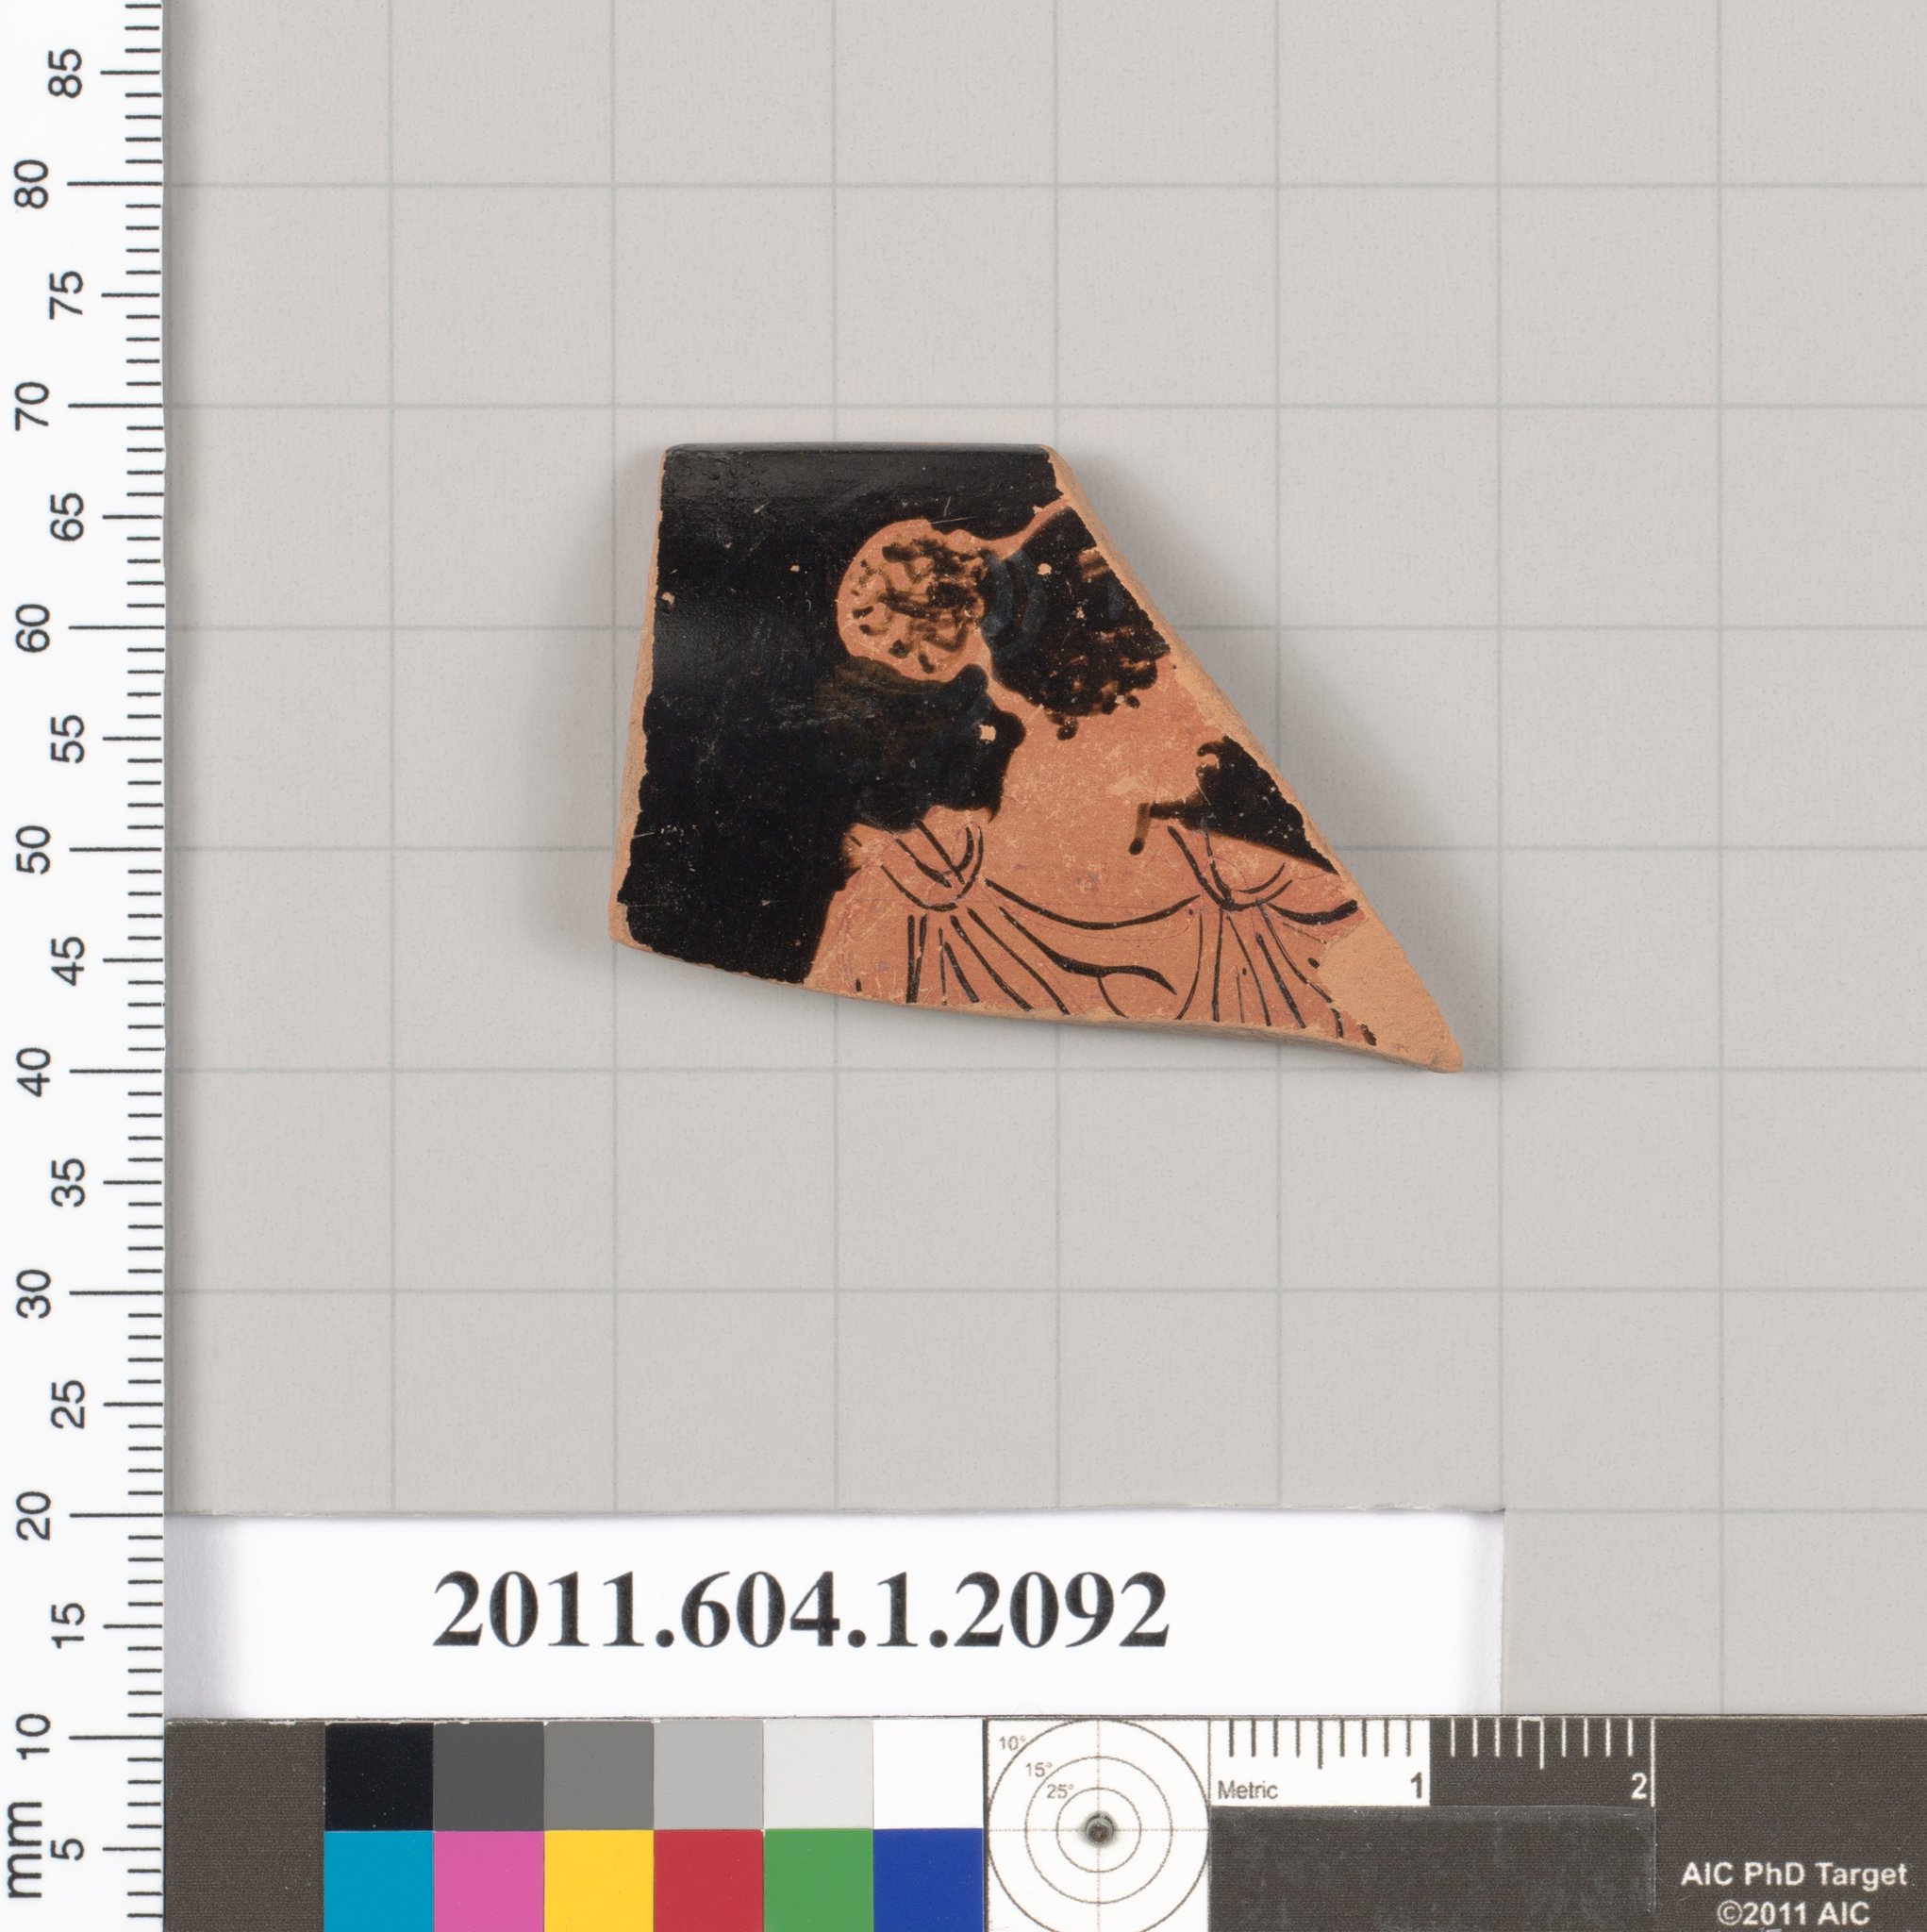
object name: kylix fragment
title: Terracotta rim fragment of a kylix (drinking cup)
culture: greek, attic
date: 460-450 BCE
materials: terracotta